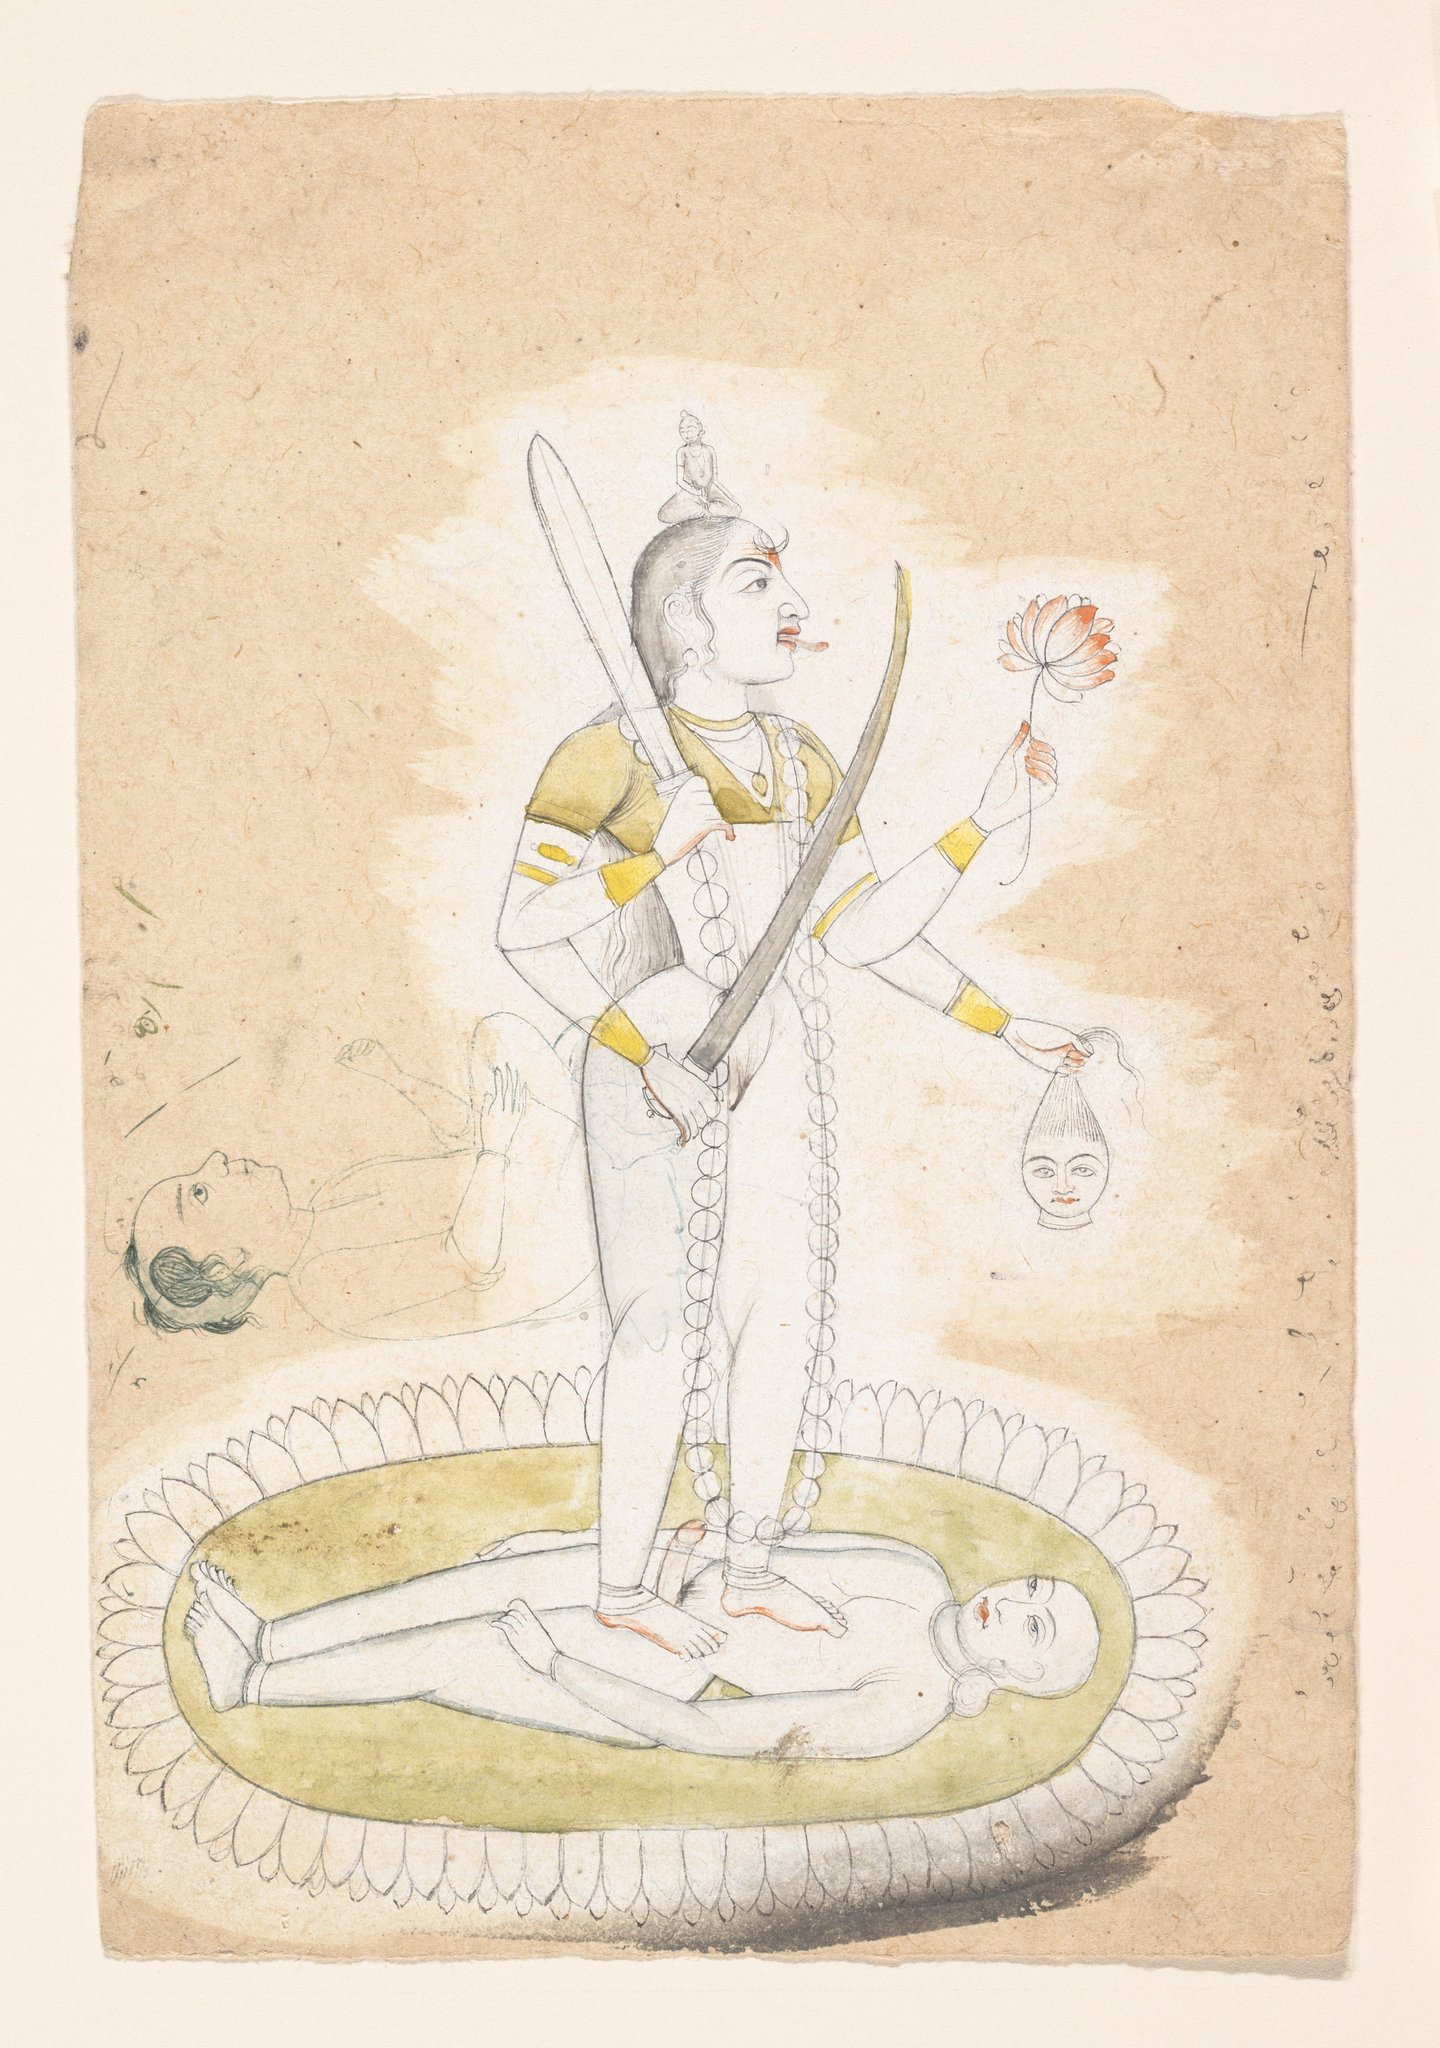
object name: painting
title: Sketch with Kali and a Young Boy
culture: indian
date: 1800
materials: ink, paper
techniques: heightening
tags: swords,heads,boys,goddess